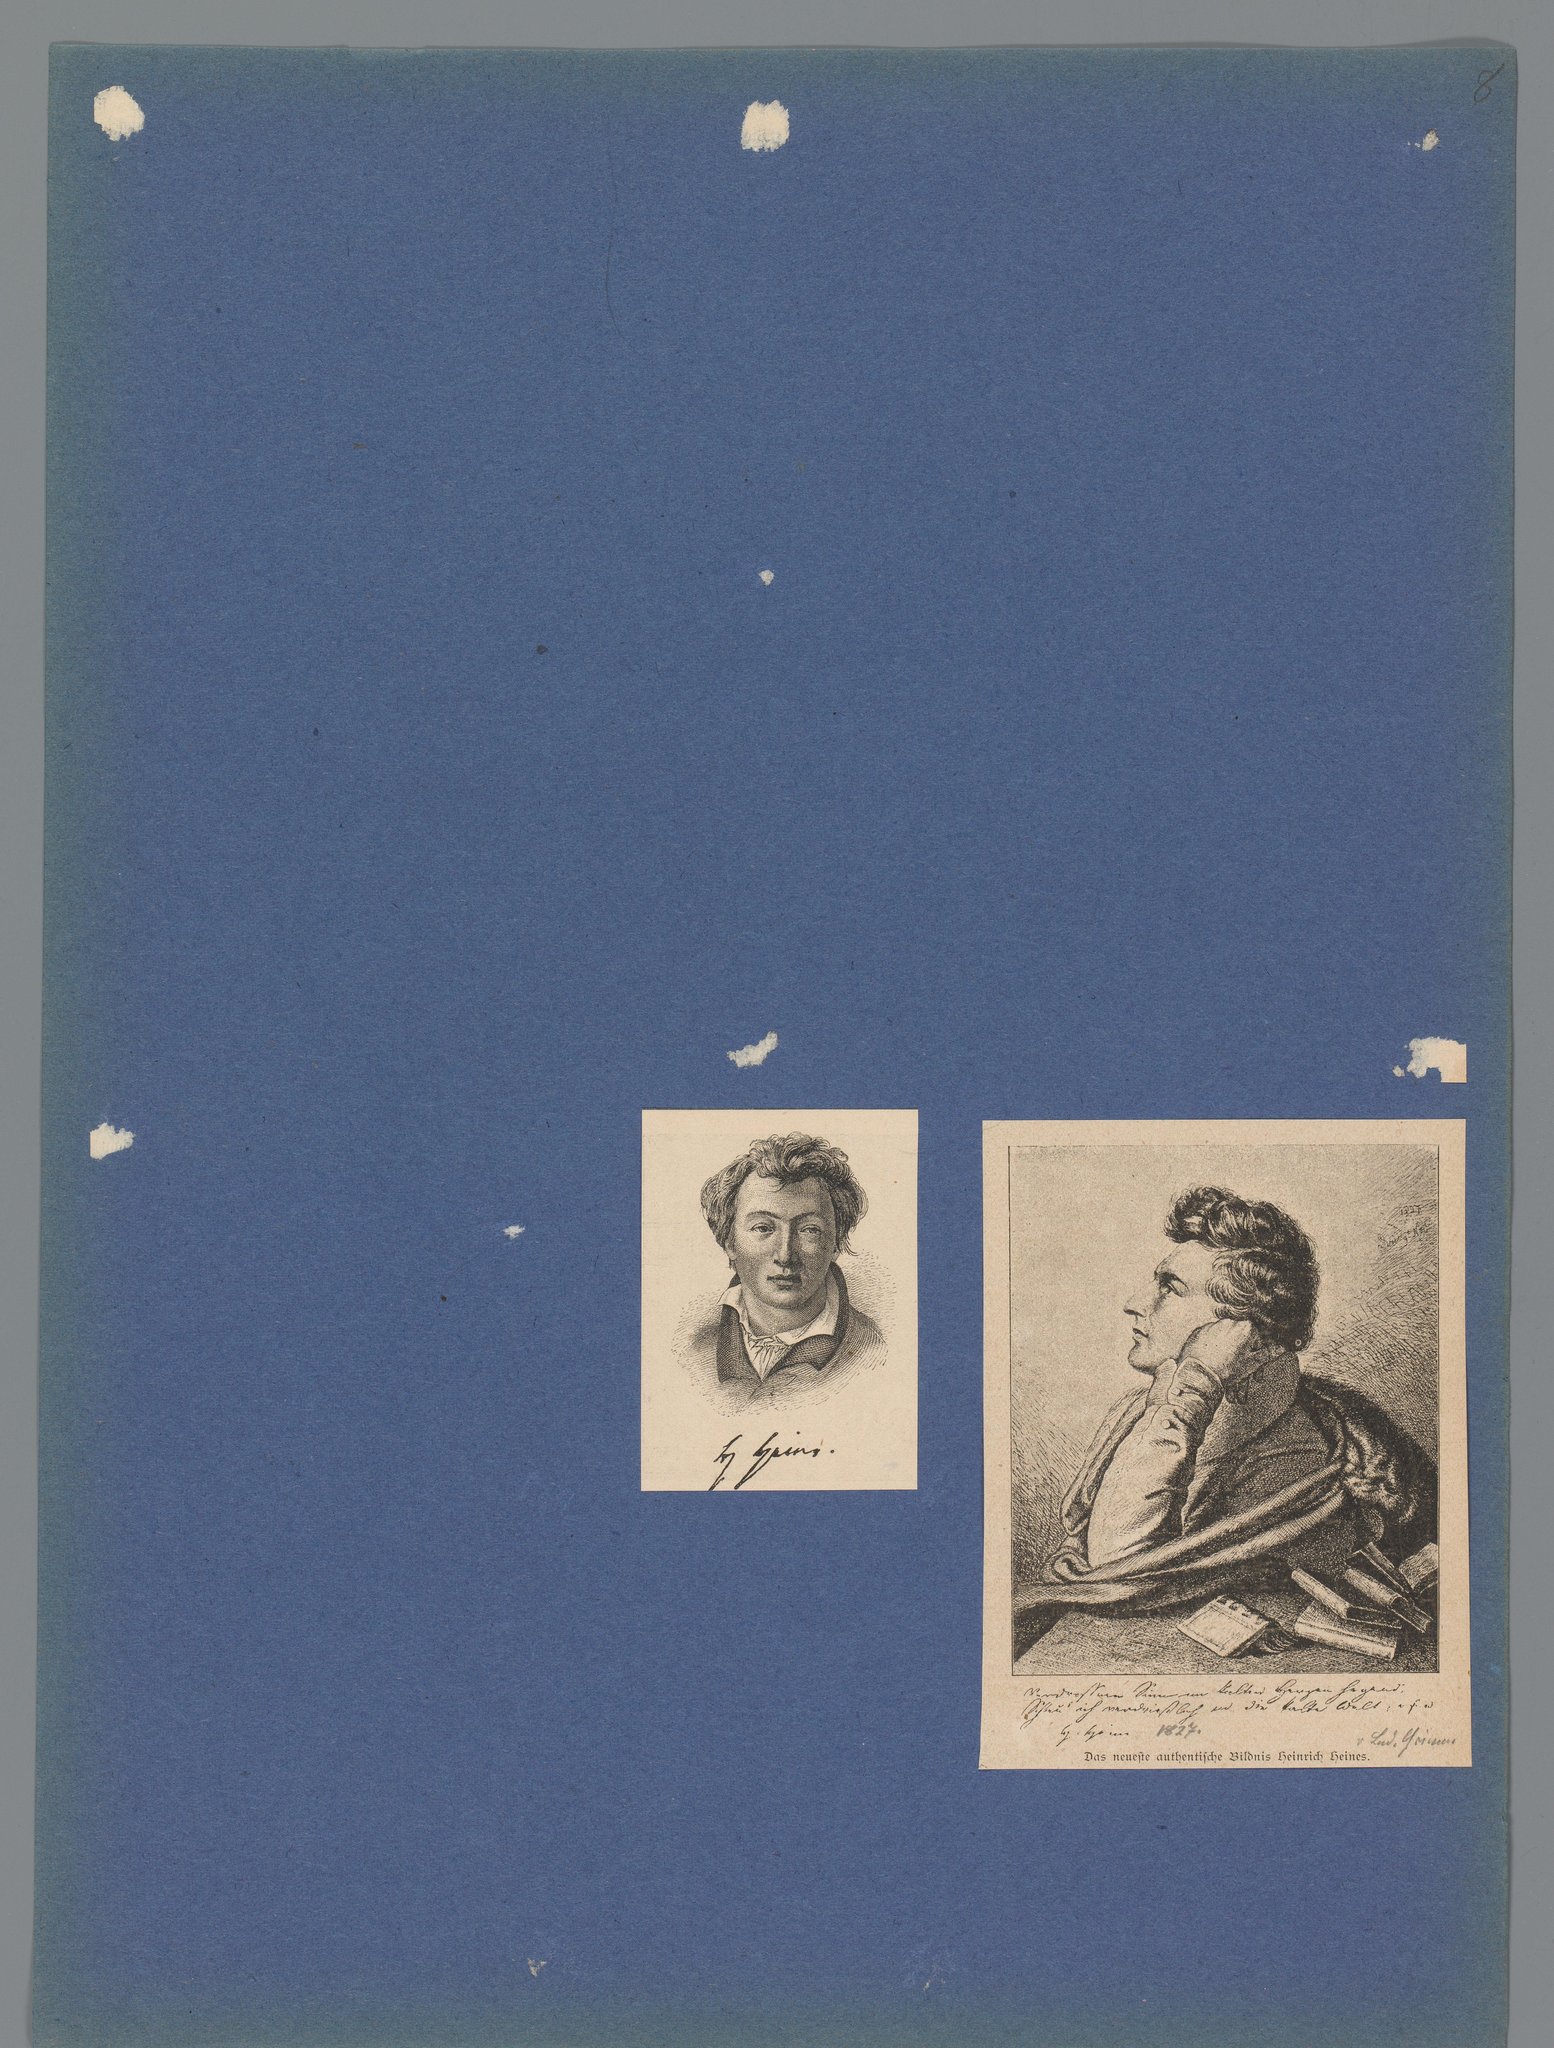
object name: sheet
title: Blad met twee portretten van Heinrich Heine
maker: Anonymous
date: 1850-1900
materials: paper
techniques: snipping, engraving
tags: paris, heinrich heine, historical persons, portrait of a writer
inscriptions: number: ‘8’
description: Met facsimile handtekening van de geportretteerde.